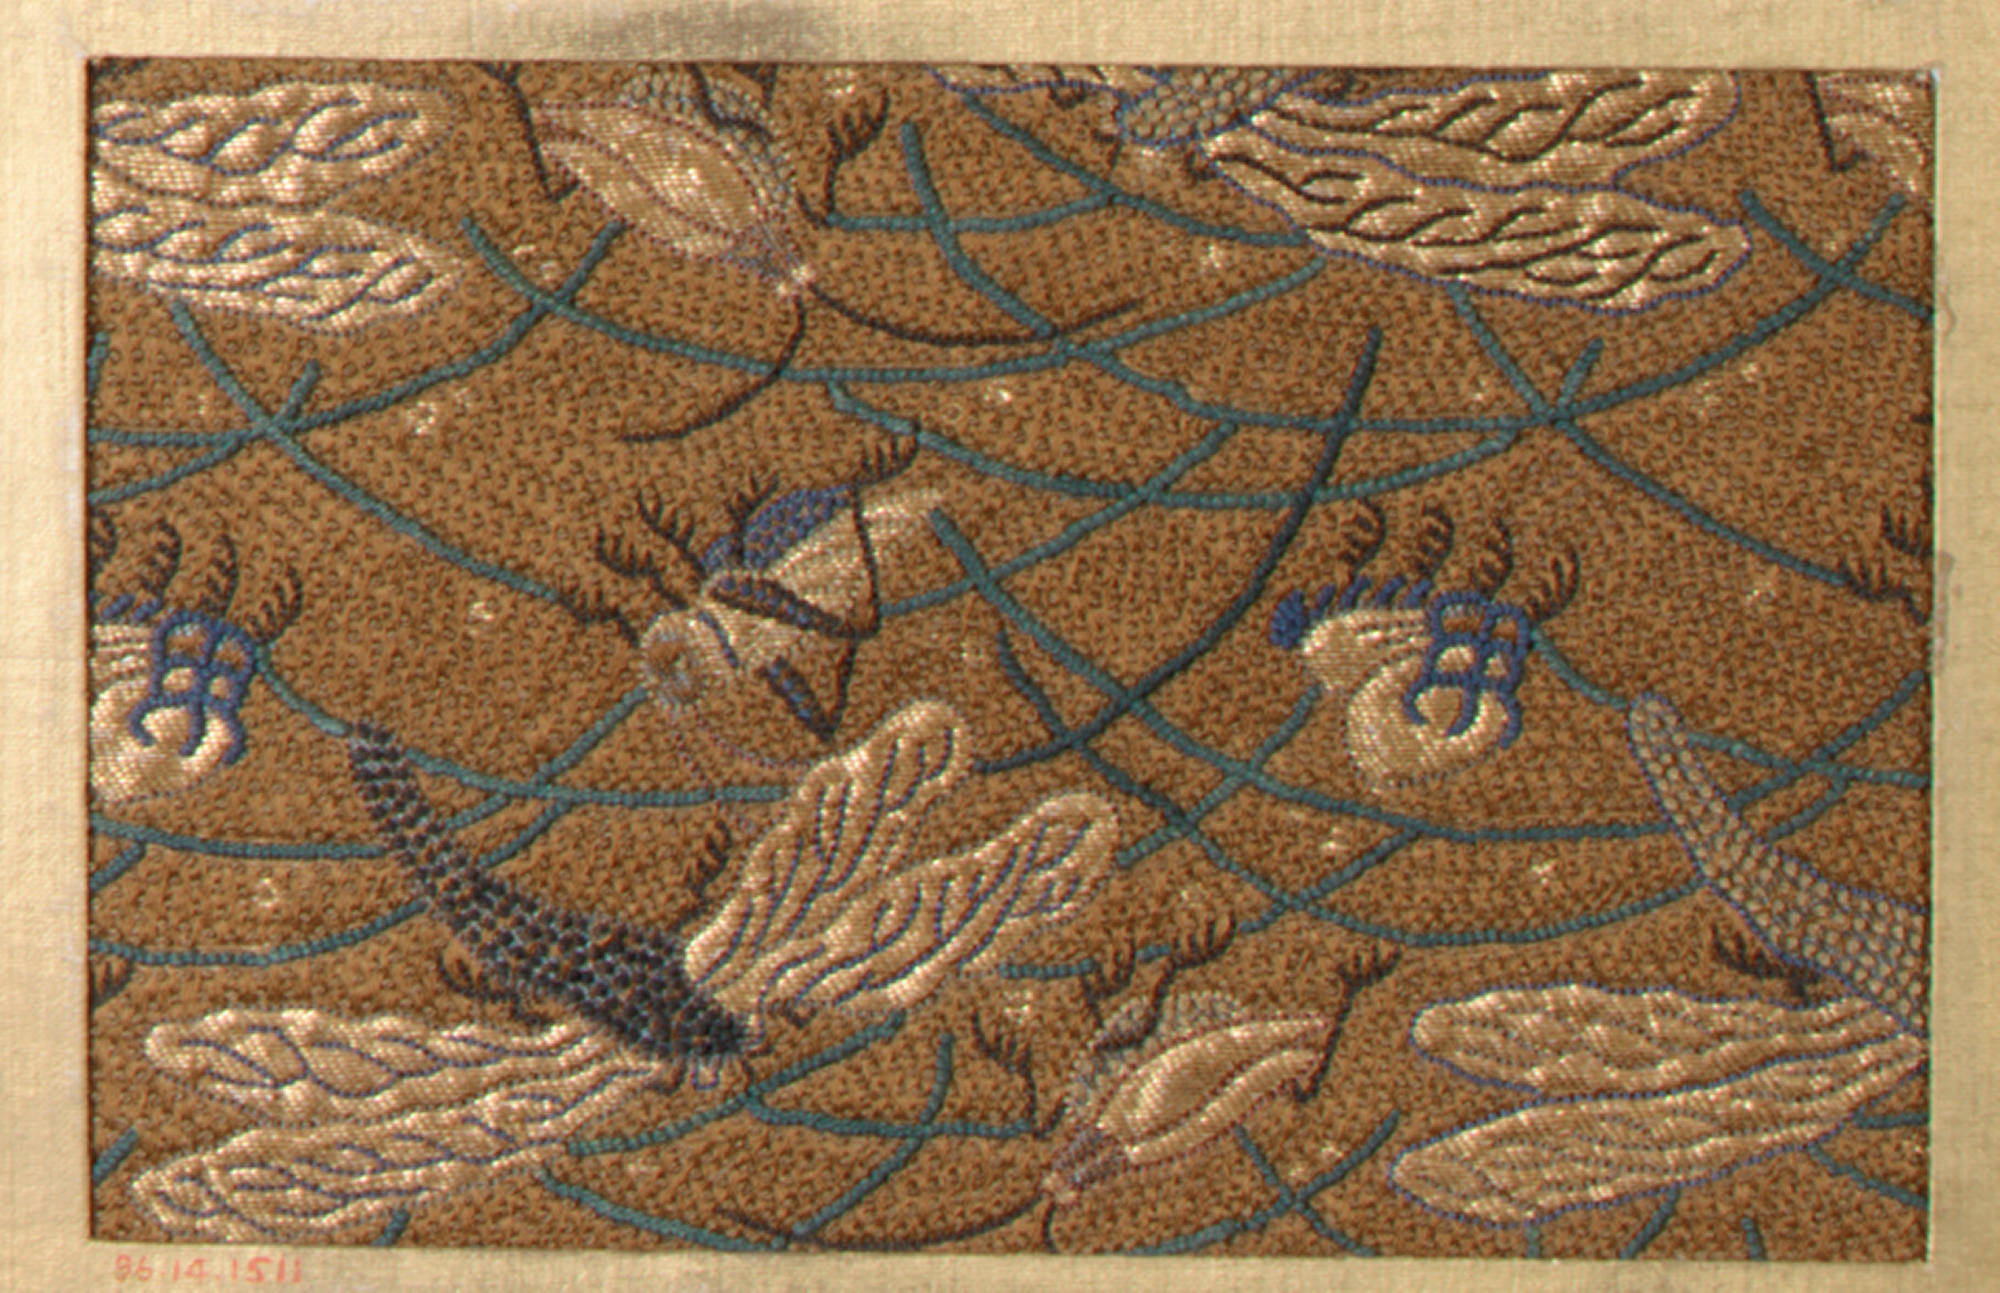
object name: piece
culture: japanese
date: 1701-1900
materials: silk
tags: dragonflies